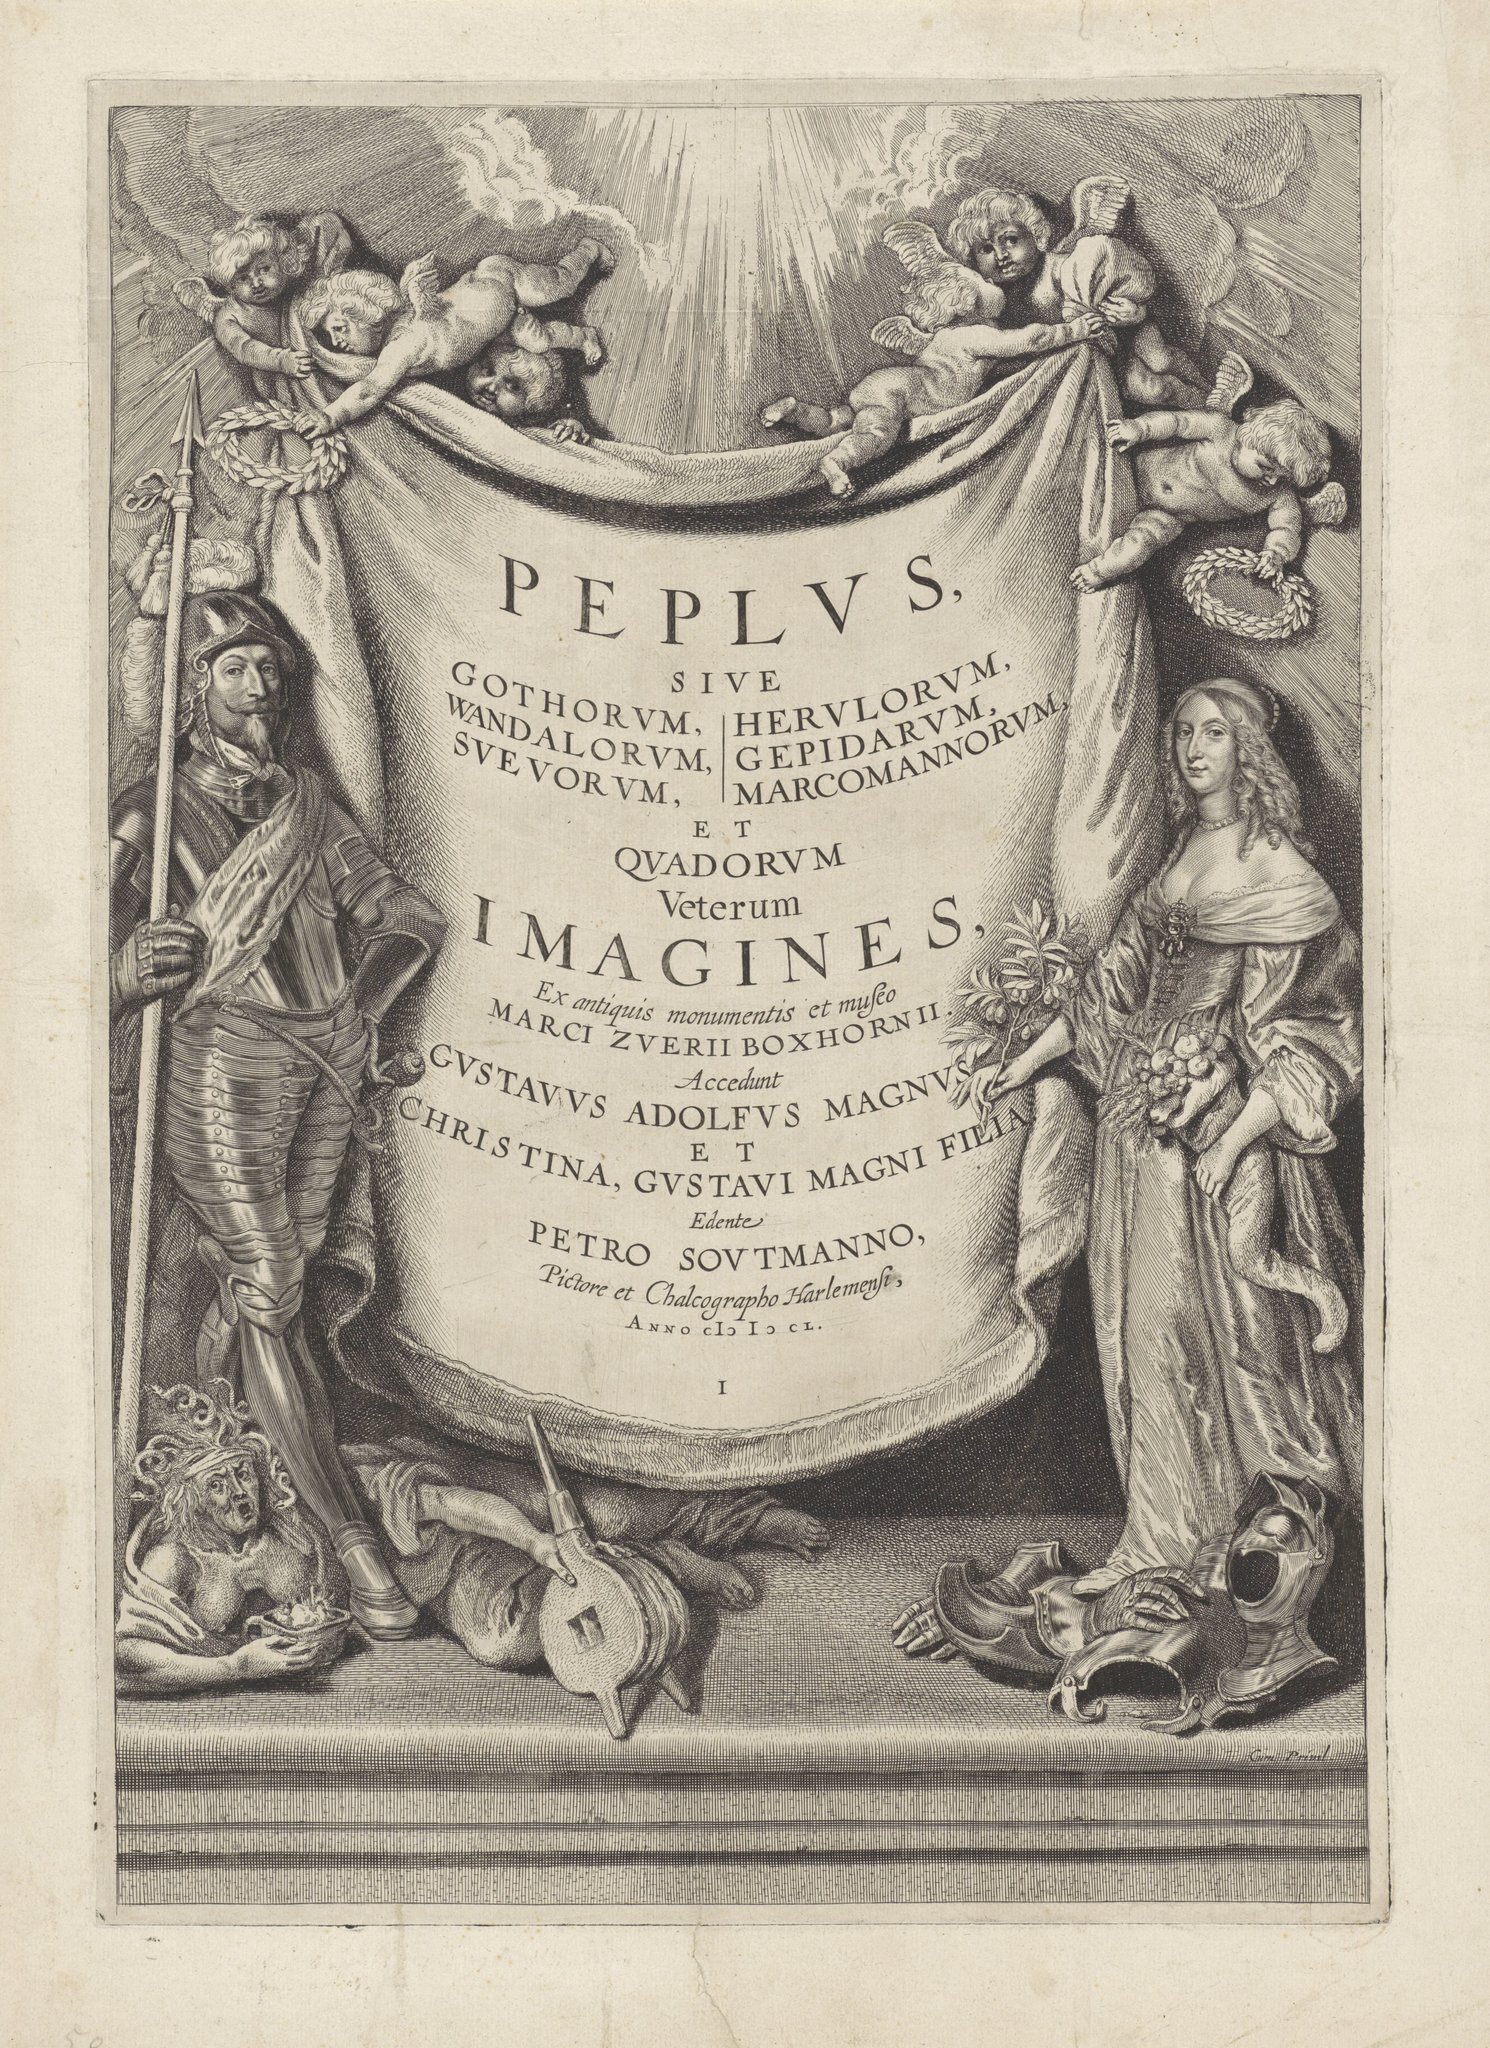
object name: print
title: Titelprent voor de reeks Peplus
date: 1650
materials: paper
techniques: engraving, etching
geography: haarlem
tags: rome, christina (koningin van zweden), 'cornucopia', horn of plenty, armour, cupids: 'amores', 'amoretti', 'putti'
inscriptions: date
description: Titelprent met de titel van de prentserie op een doek opgehouden door engelen. Links Gustaaf II Adolf, koning van Zweden, die de Afgunst vertrapt, rechts koningin Christina van Zweden staande op delen wapenrusting.